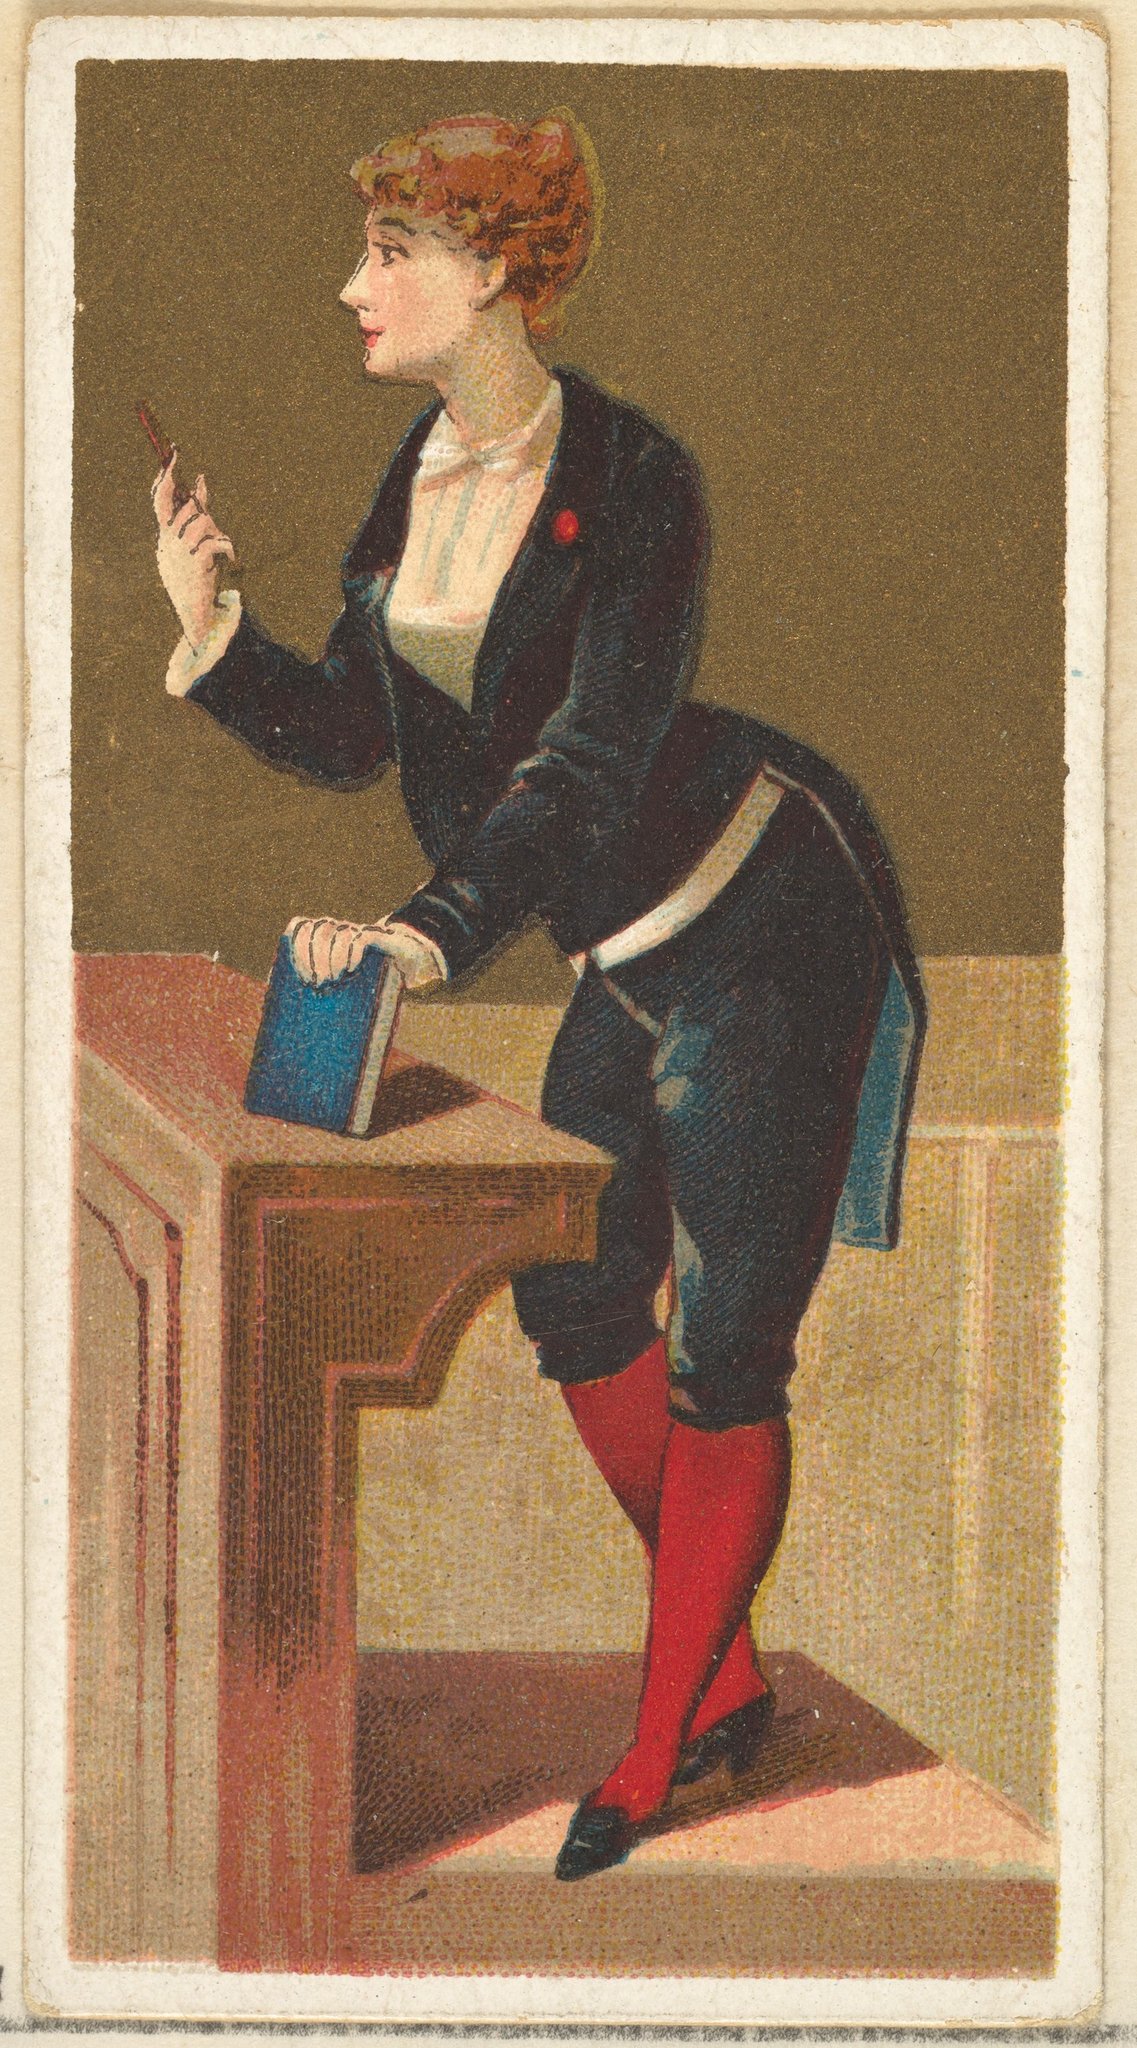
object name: print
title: Teacher, from the Occupations for Women series (N166) for Old Judge and Dogs Head Cigarettes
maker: goodwin & company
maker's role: publisher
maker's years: 1850-1950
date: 1887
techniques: color lithograph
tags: books,profiles,women,teachers